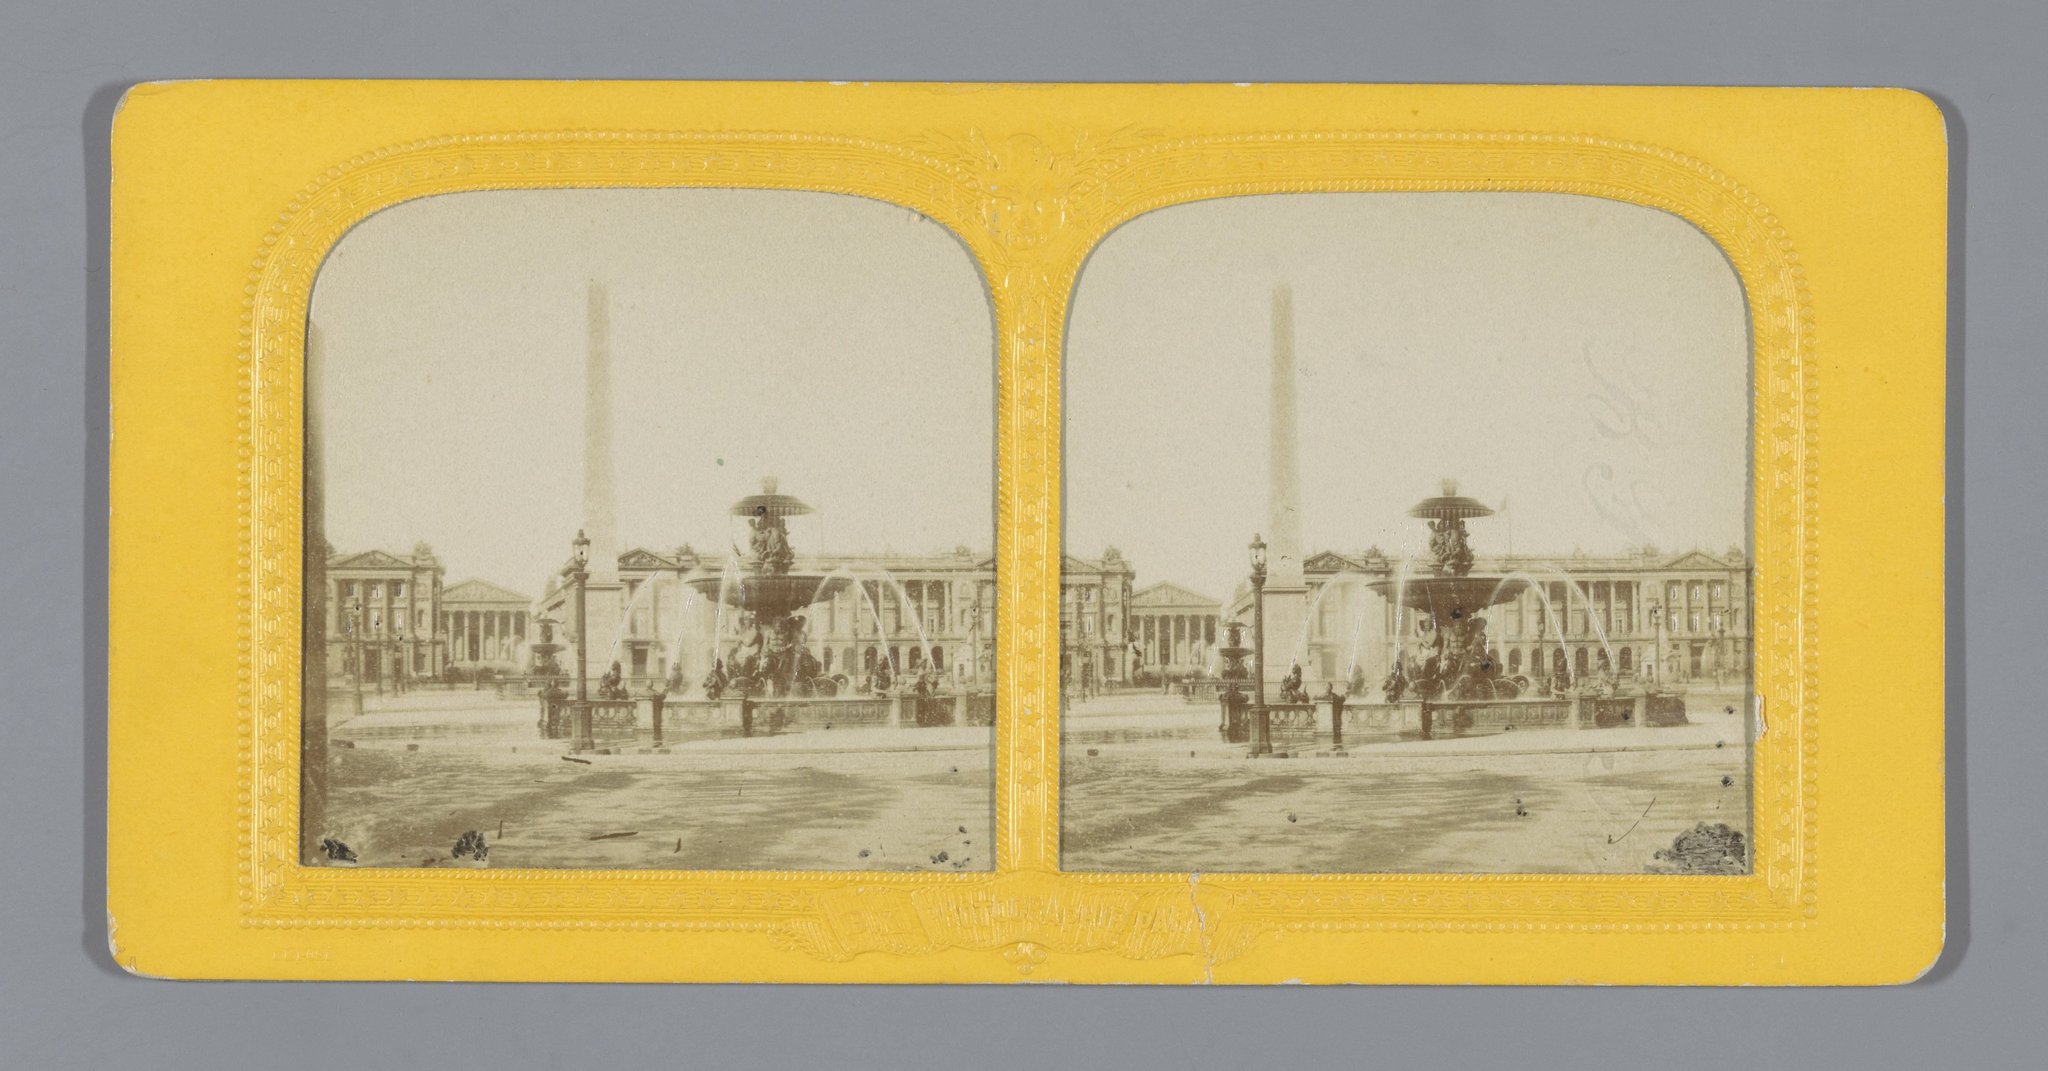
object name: tissue stereograph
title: Place de la Concorde, Paris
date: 1863-1875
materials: cardboard, paper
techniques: albumen print, hand coloring, perforating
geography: paris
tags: ornamental fountain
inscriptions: watermark: ‘BF K’, inscription: ‘Déposé’, name: ‘B.K. PHOTOGRAPHIE’, monogram: ‘E.L.’